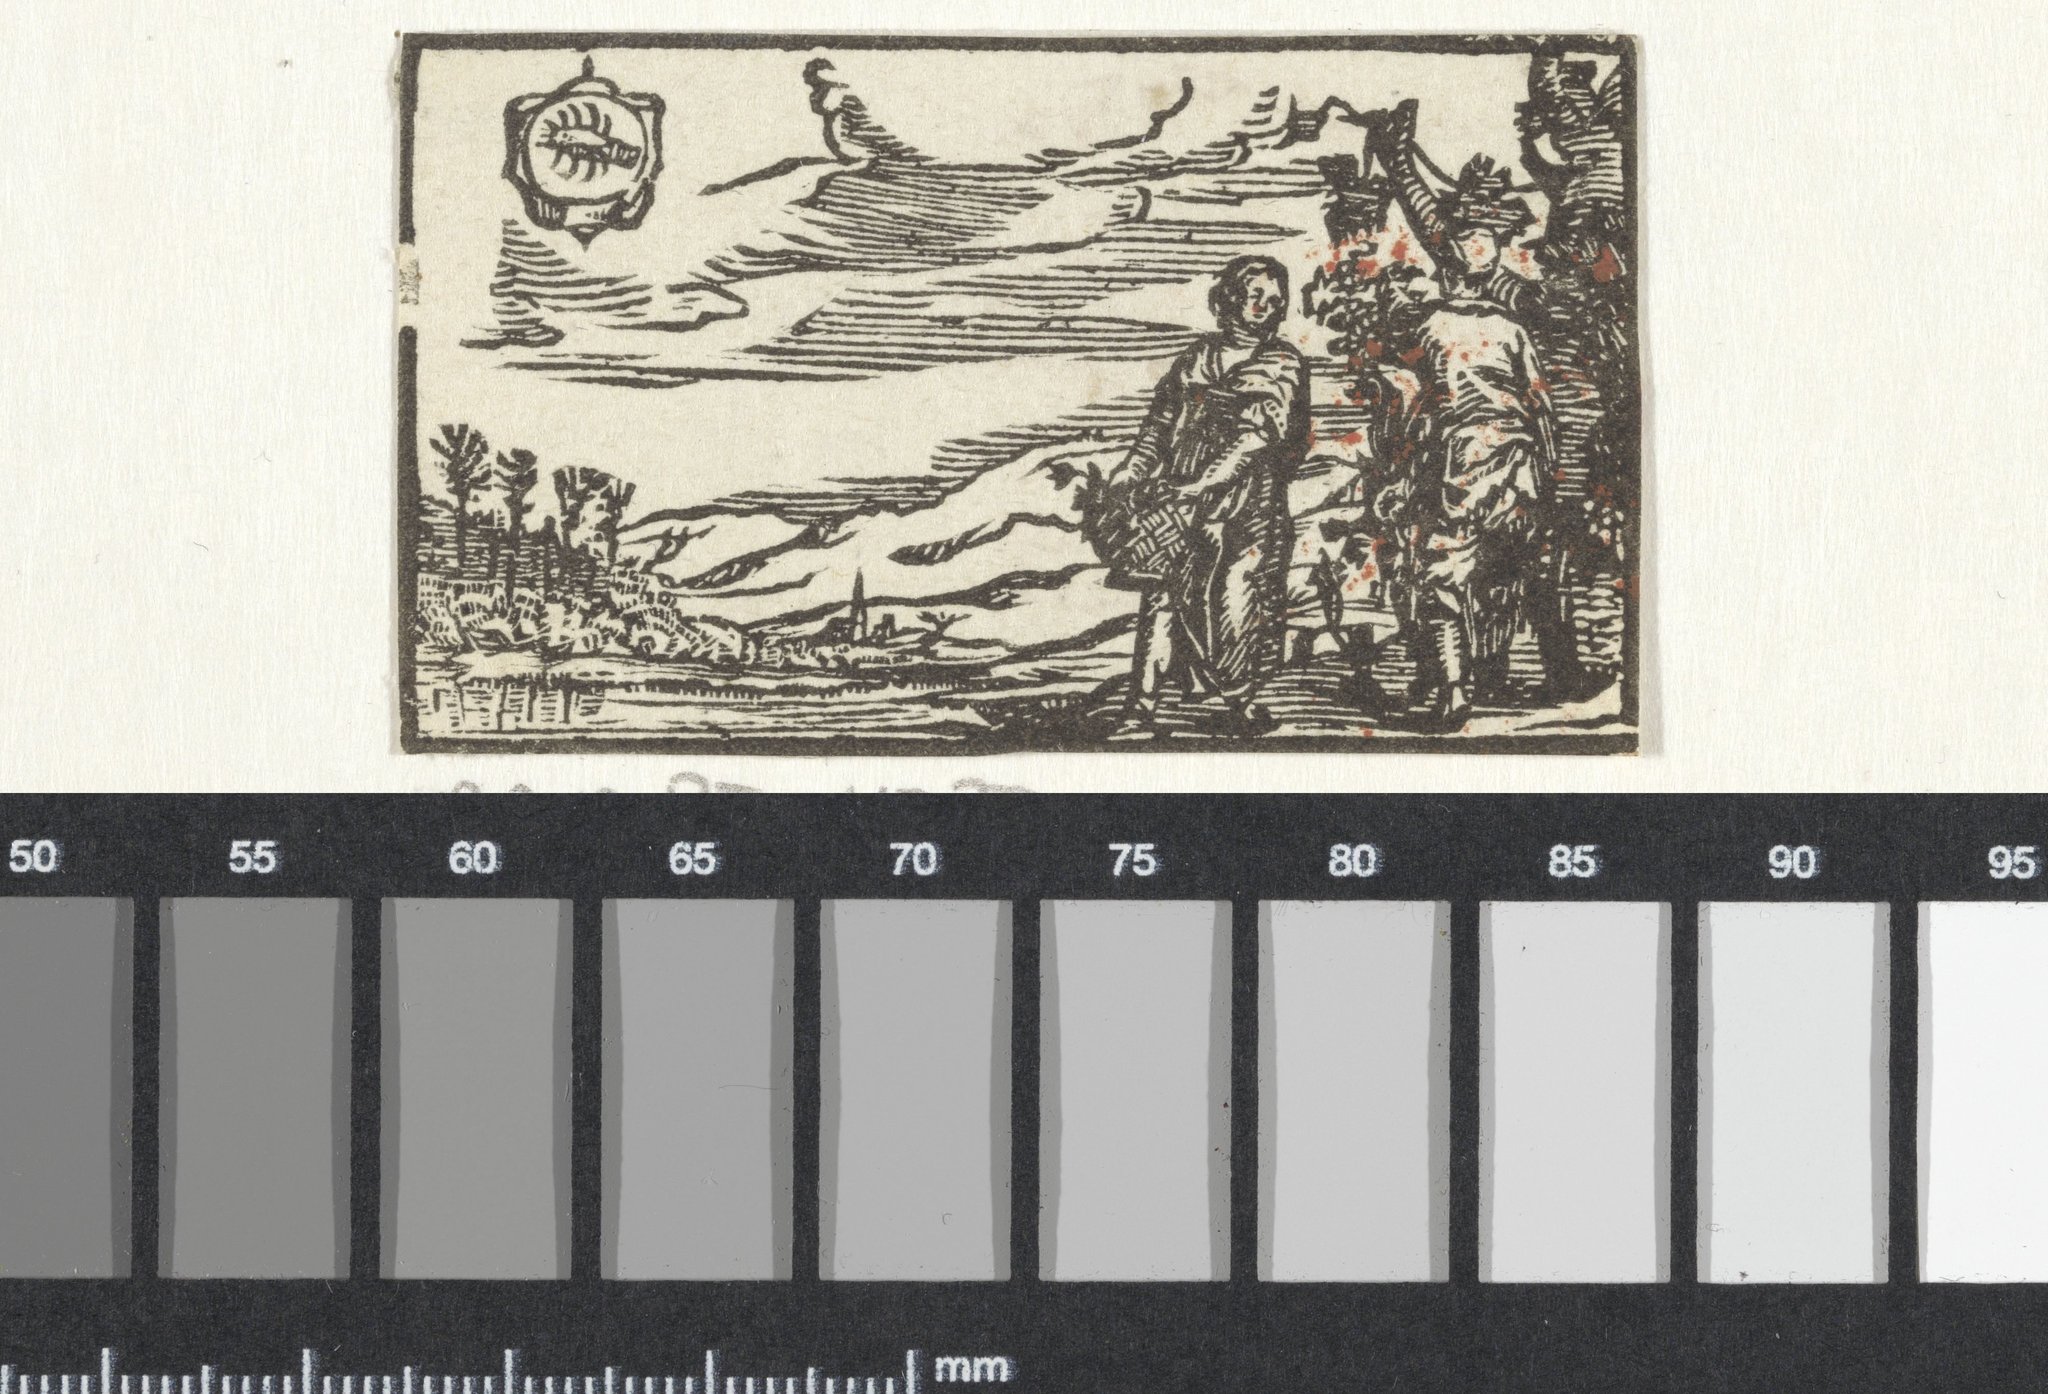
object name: print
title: Oktober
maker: Anonymous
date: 1600-1699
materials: paper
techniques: woodcut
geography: netherlands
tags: october and its 'labours' (+ with scorpio (october)), vintage, grape harvest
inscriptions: collector's mark: Lugt 240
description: Een vrouw met een mand en een man druiven plukkend in een boomgaard. Linksboven een schorpioen.